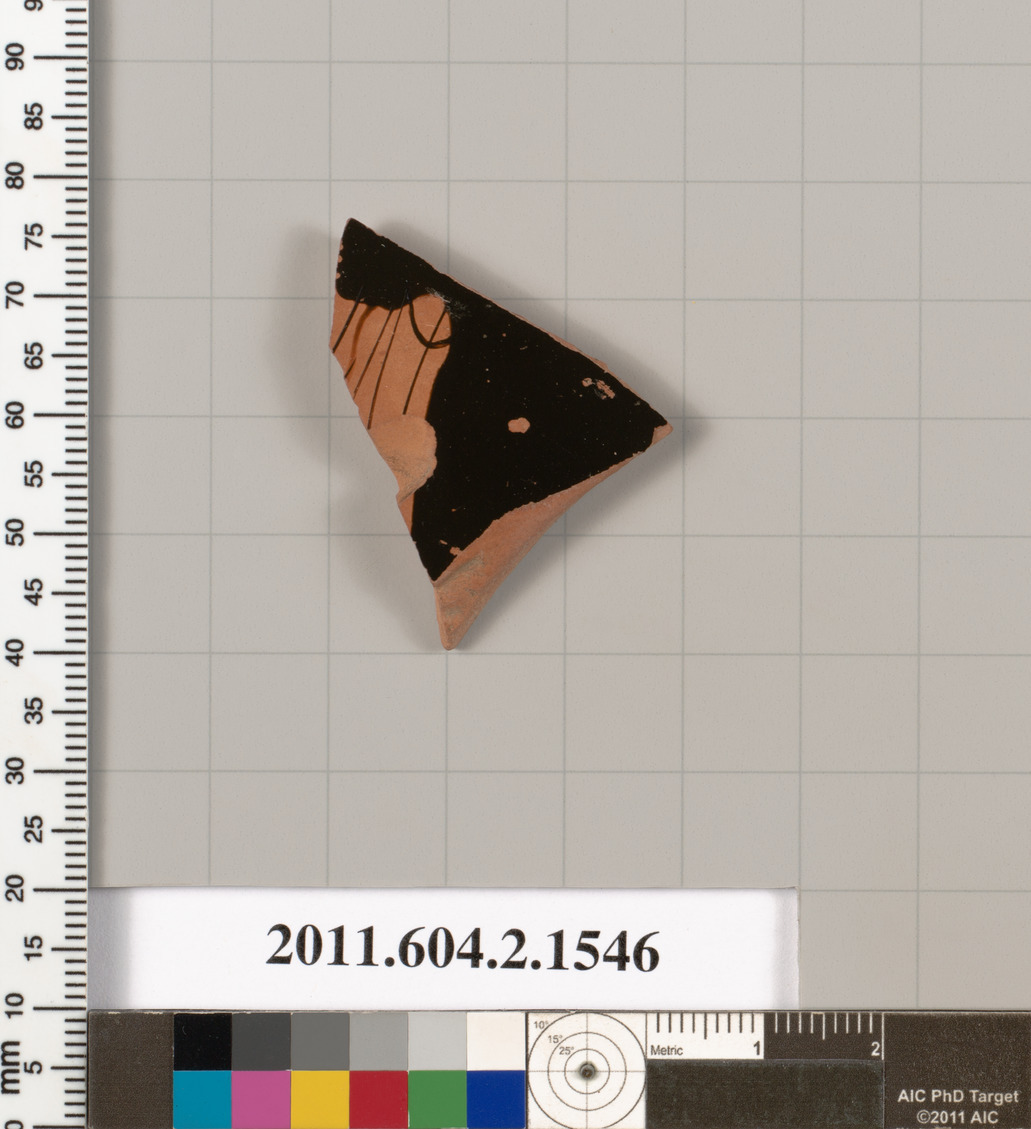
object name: skyphos fragment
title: Terracotta fragment of a skyphos (deep drinking cup)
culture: greek, attic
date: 450-426 BCE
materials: terracotta